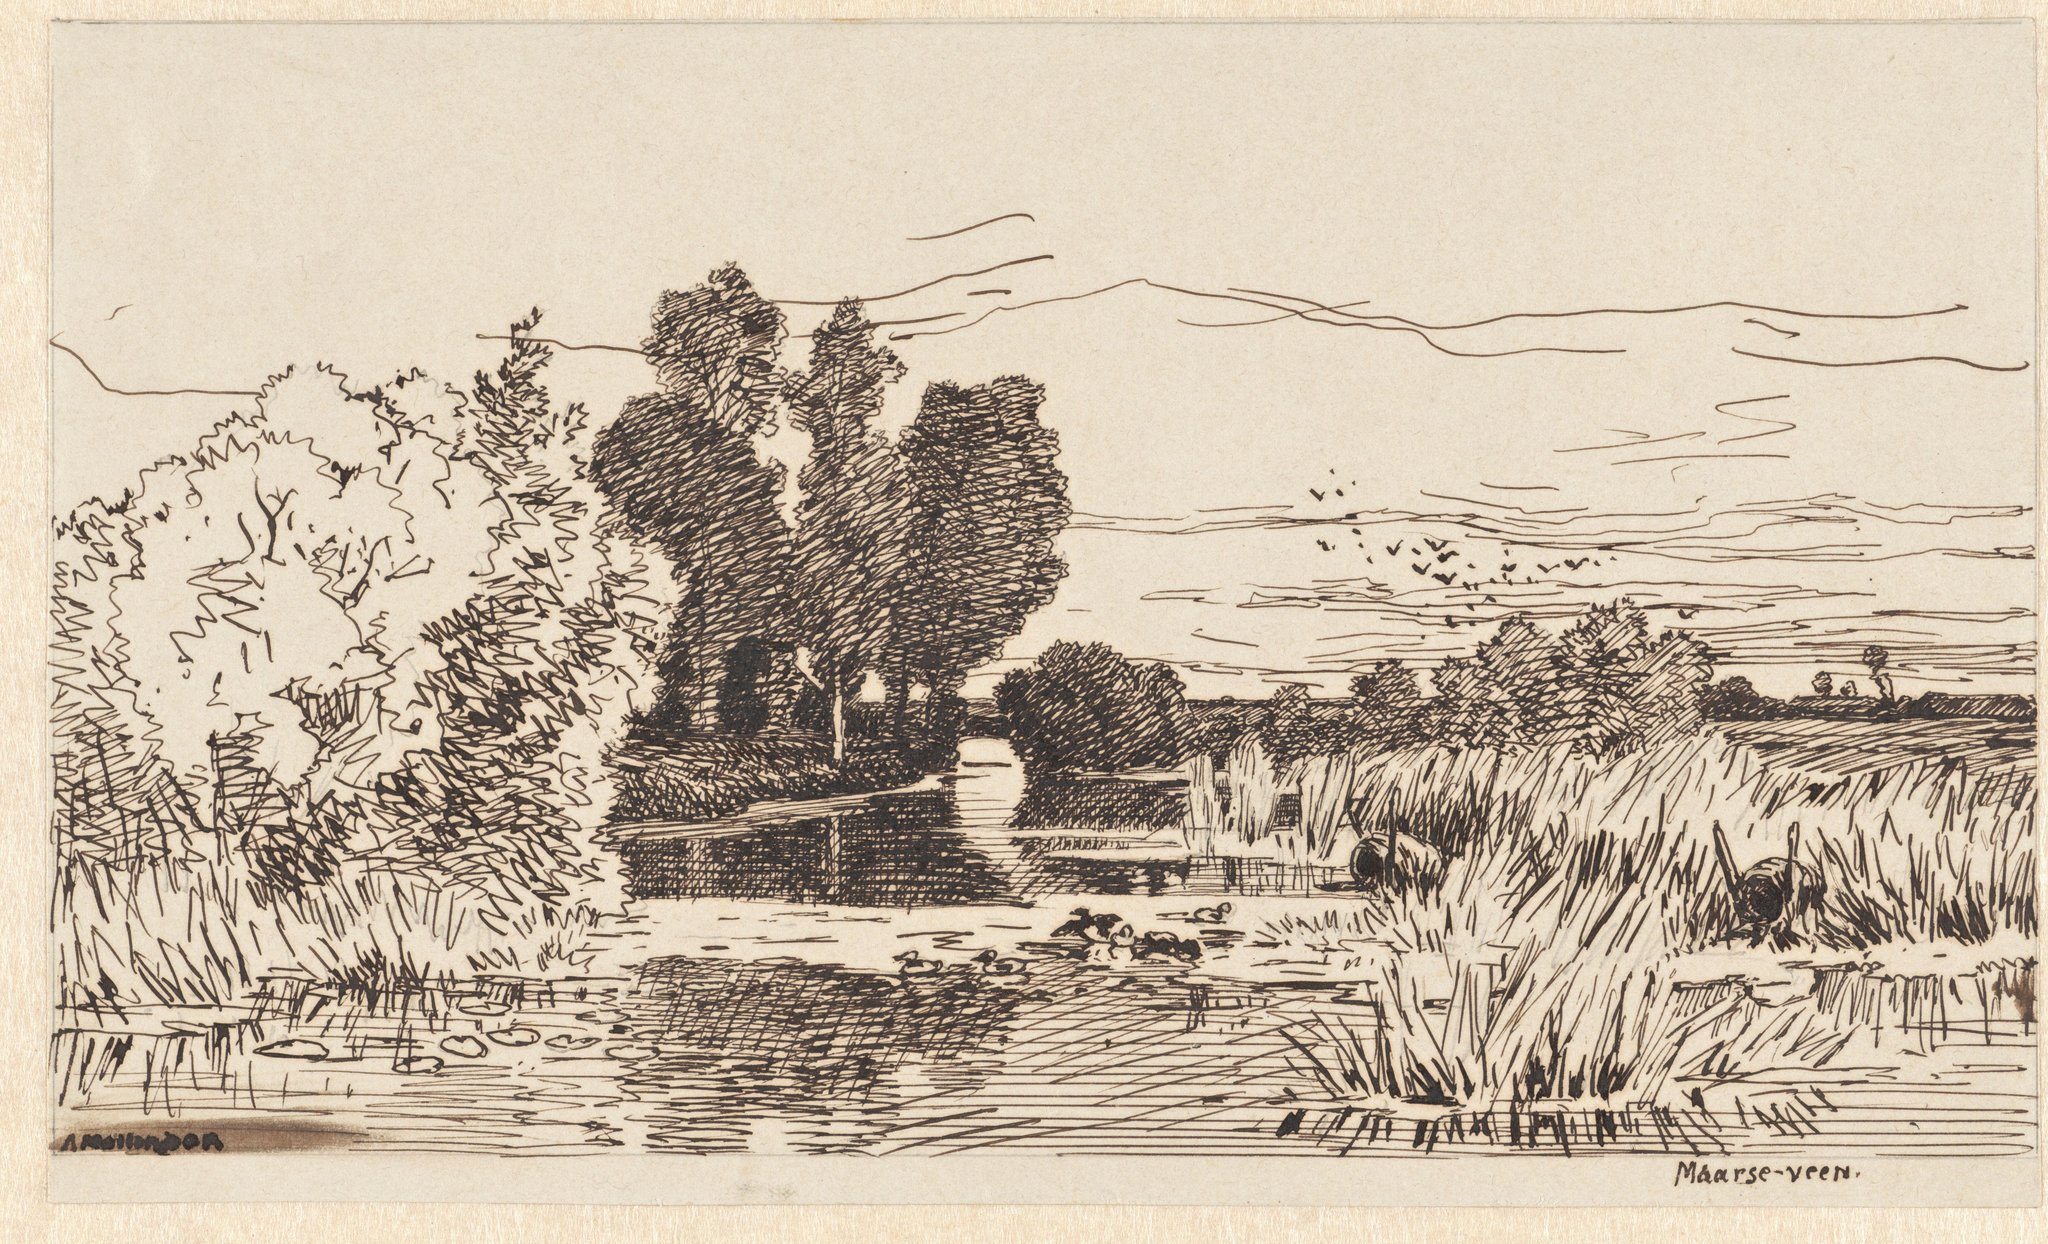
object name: drawing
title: Rivierlandschap Maarseveen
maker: alexander mollinger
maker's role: painter, print maker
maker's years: 1836-1867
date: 1846-1867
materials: ink, paper, pencil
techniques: pen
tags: river